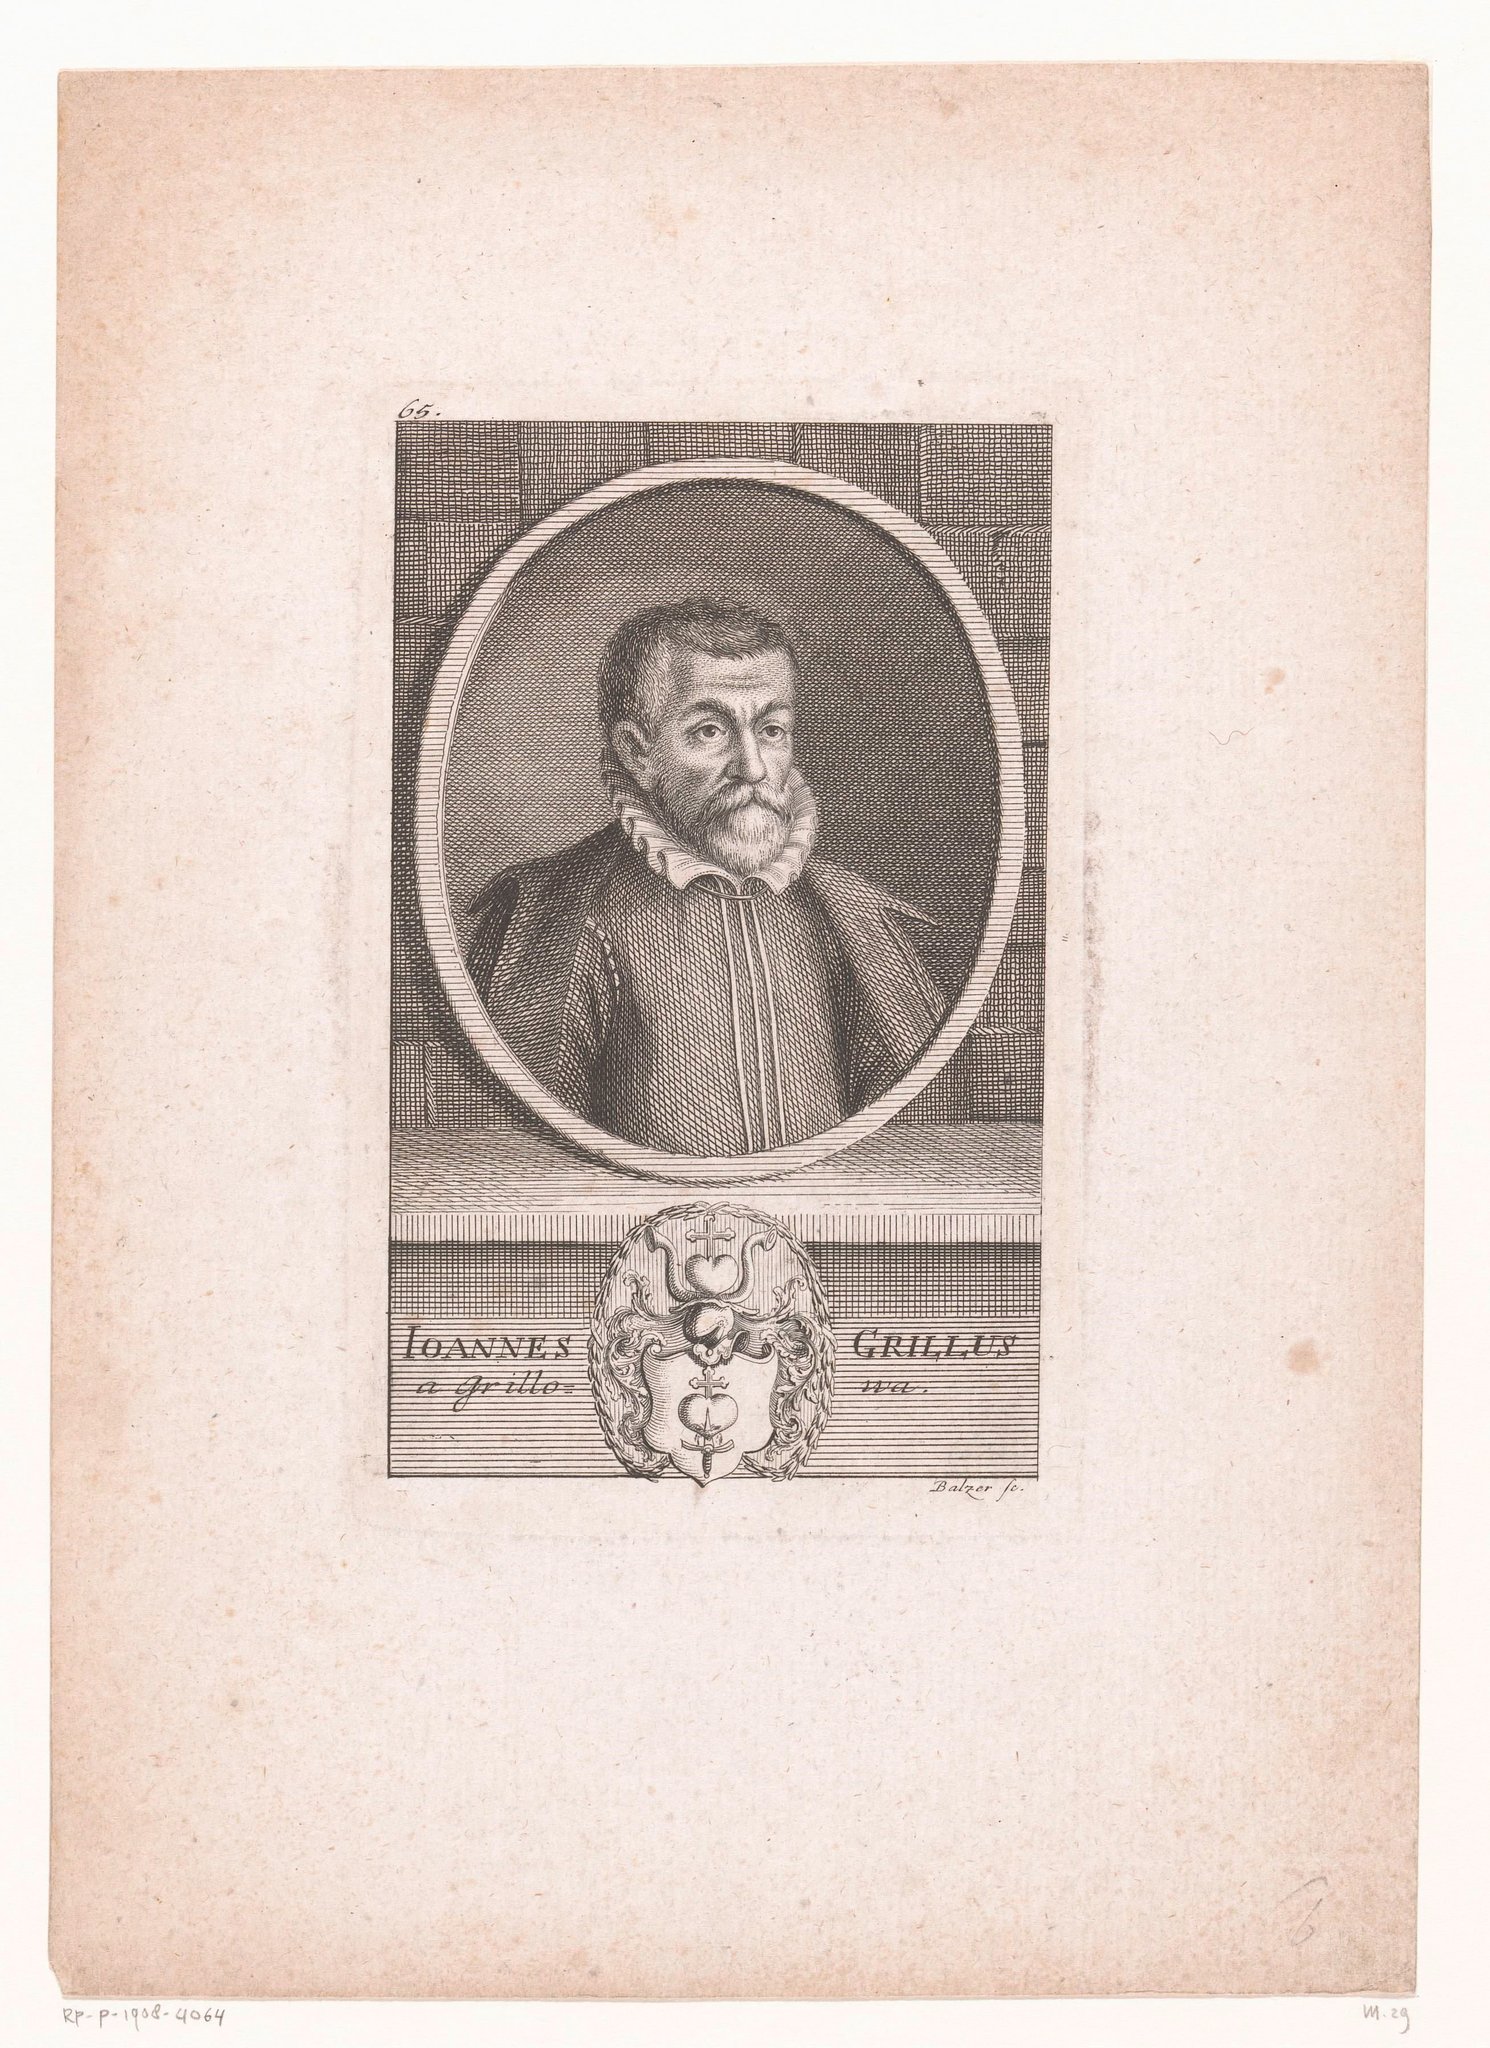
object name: print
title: Ioannes Grillus a Grillowa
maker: jan balzer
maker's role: print maker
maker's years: 1736-1799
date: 1746-1799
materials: paper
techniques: engraving, etching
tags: historical persons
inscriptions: collector's mark: Lugt 2228